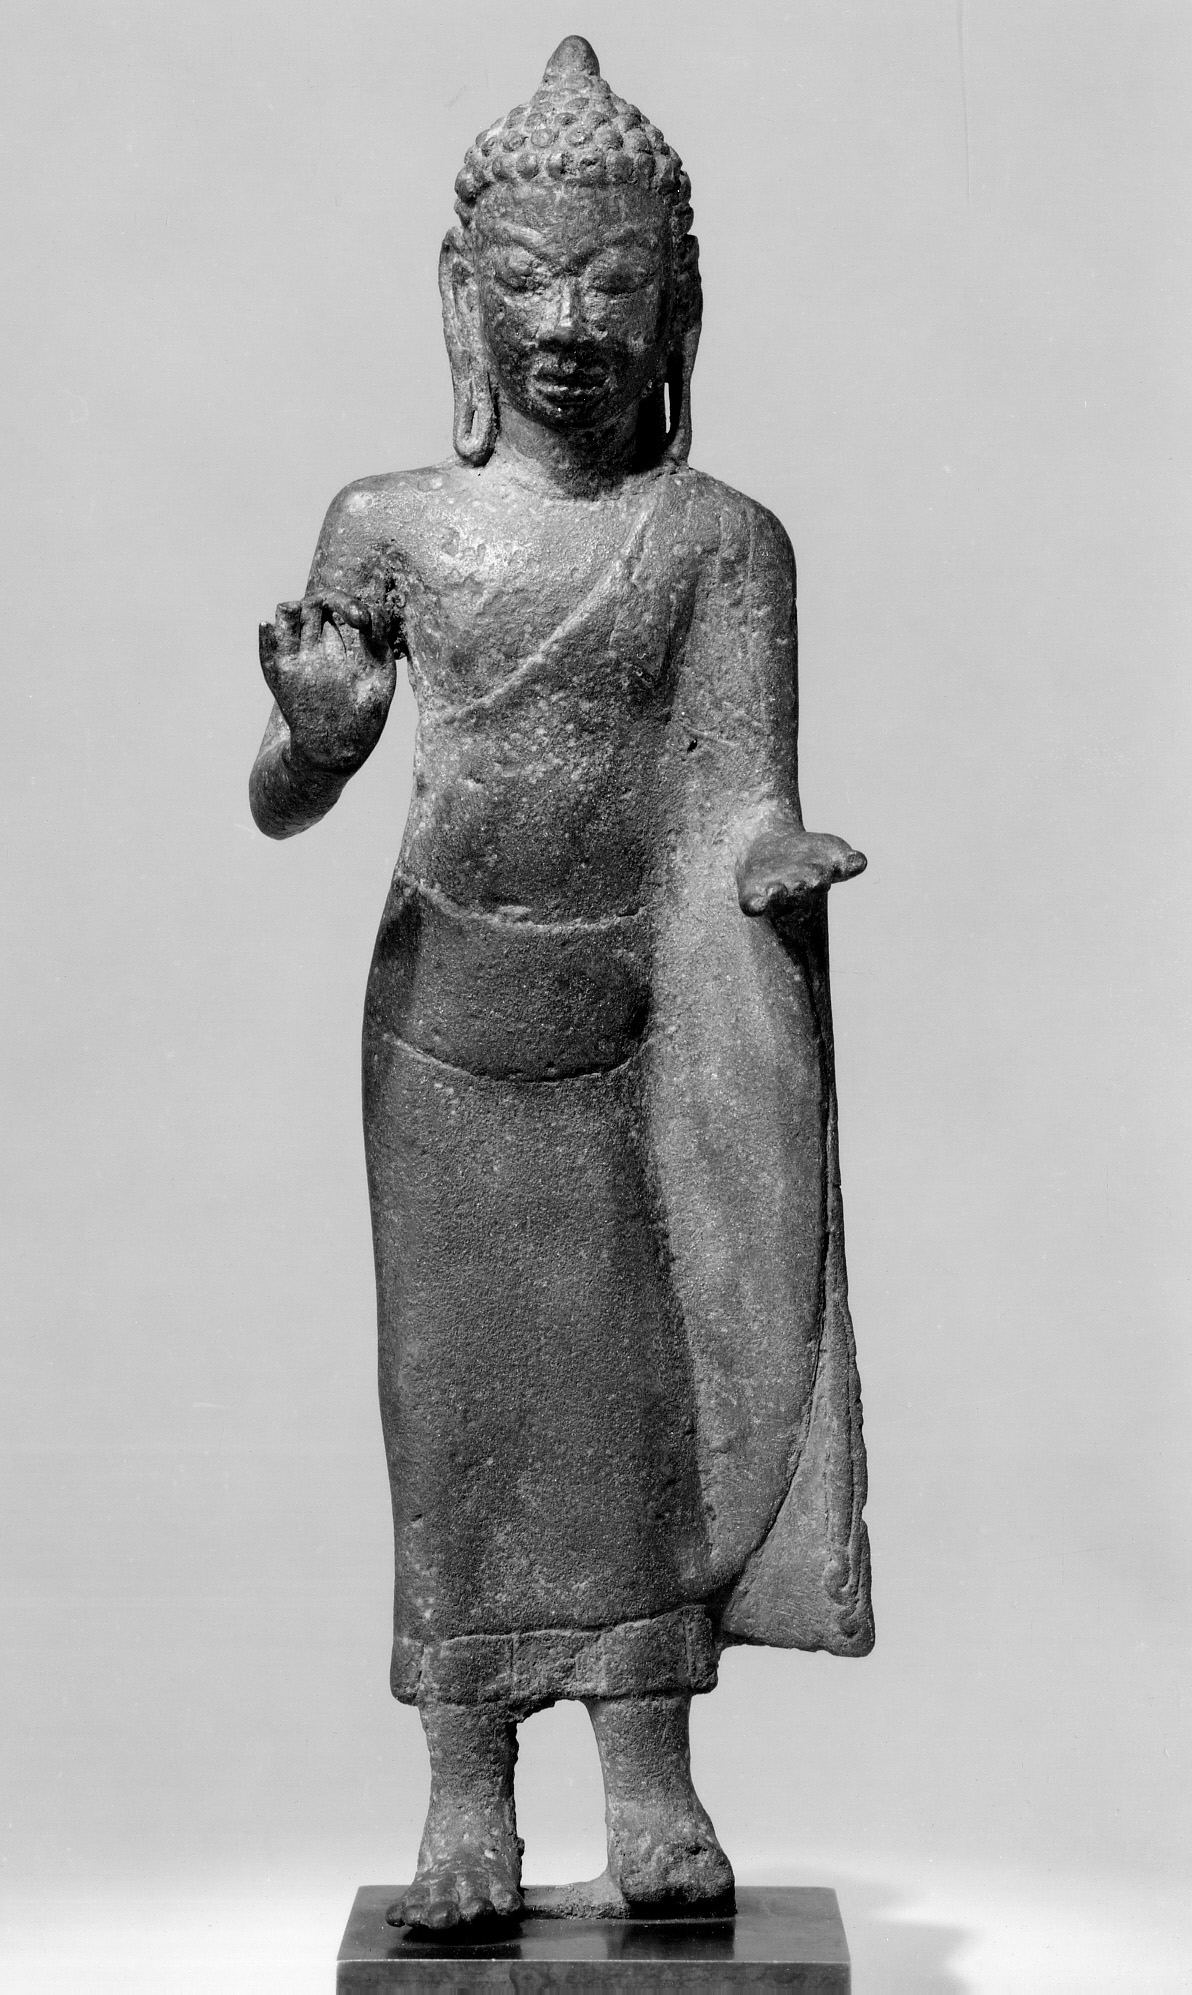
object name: figure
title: Standing Buddha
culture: thai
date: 701-900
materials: bronze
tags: buddhism,buddha